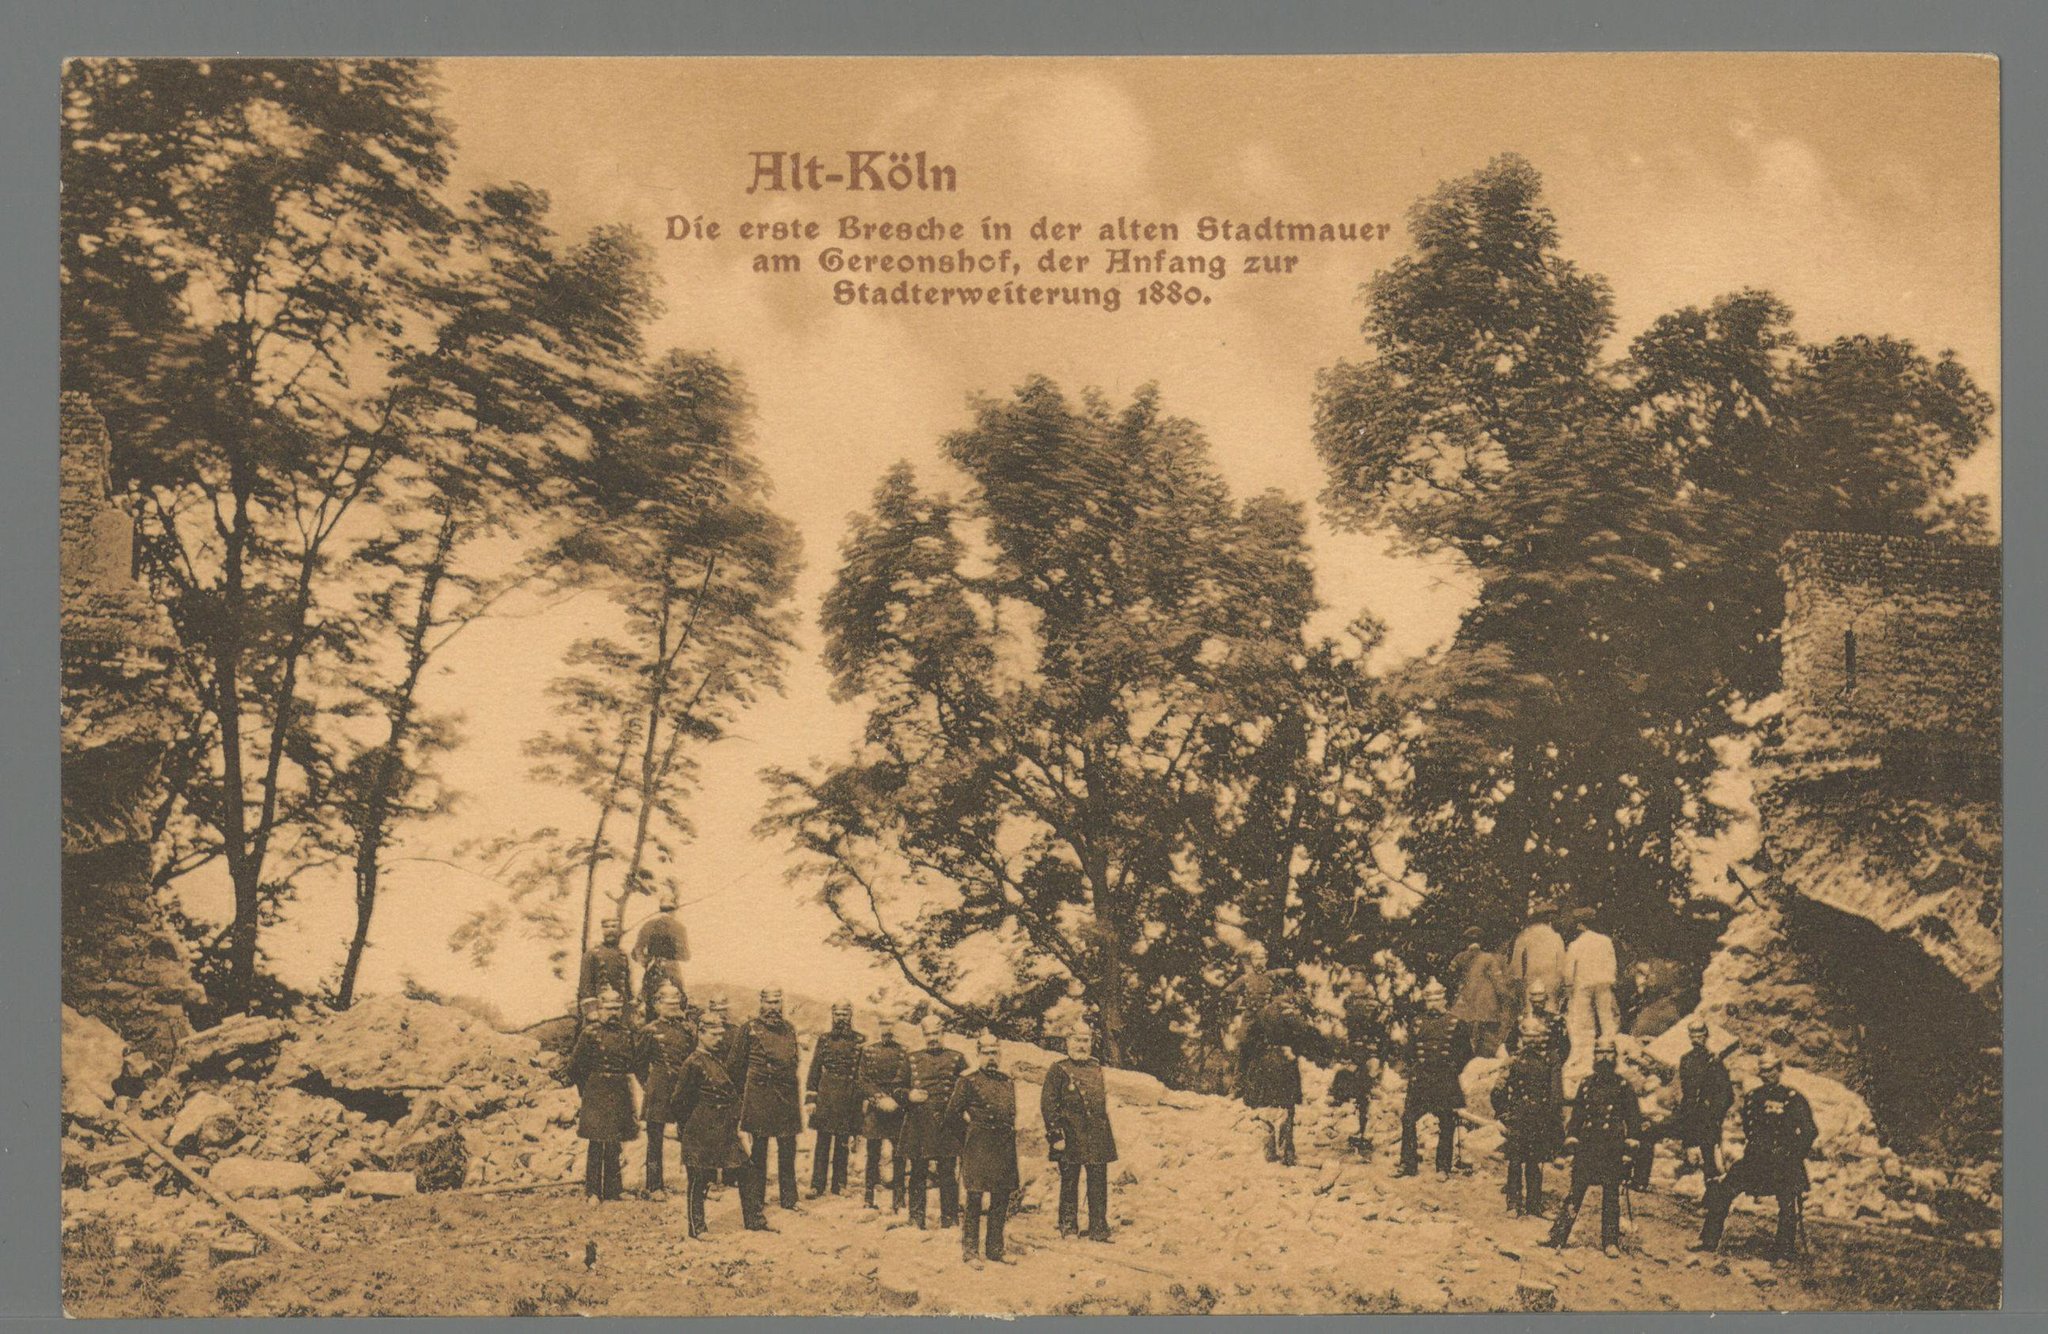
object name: photomechanical print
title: Alt-Köln. Die erste Bresche in der alten Stadtmauer am Gereonshof, der Anfang zur Stadterweiterung 1880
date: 1905-1920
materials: cardboard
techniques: photograph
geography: cologne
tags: city-walls, cologne